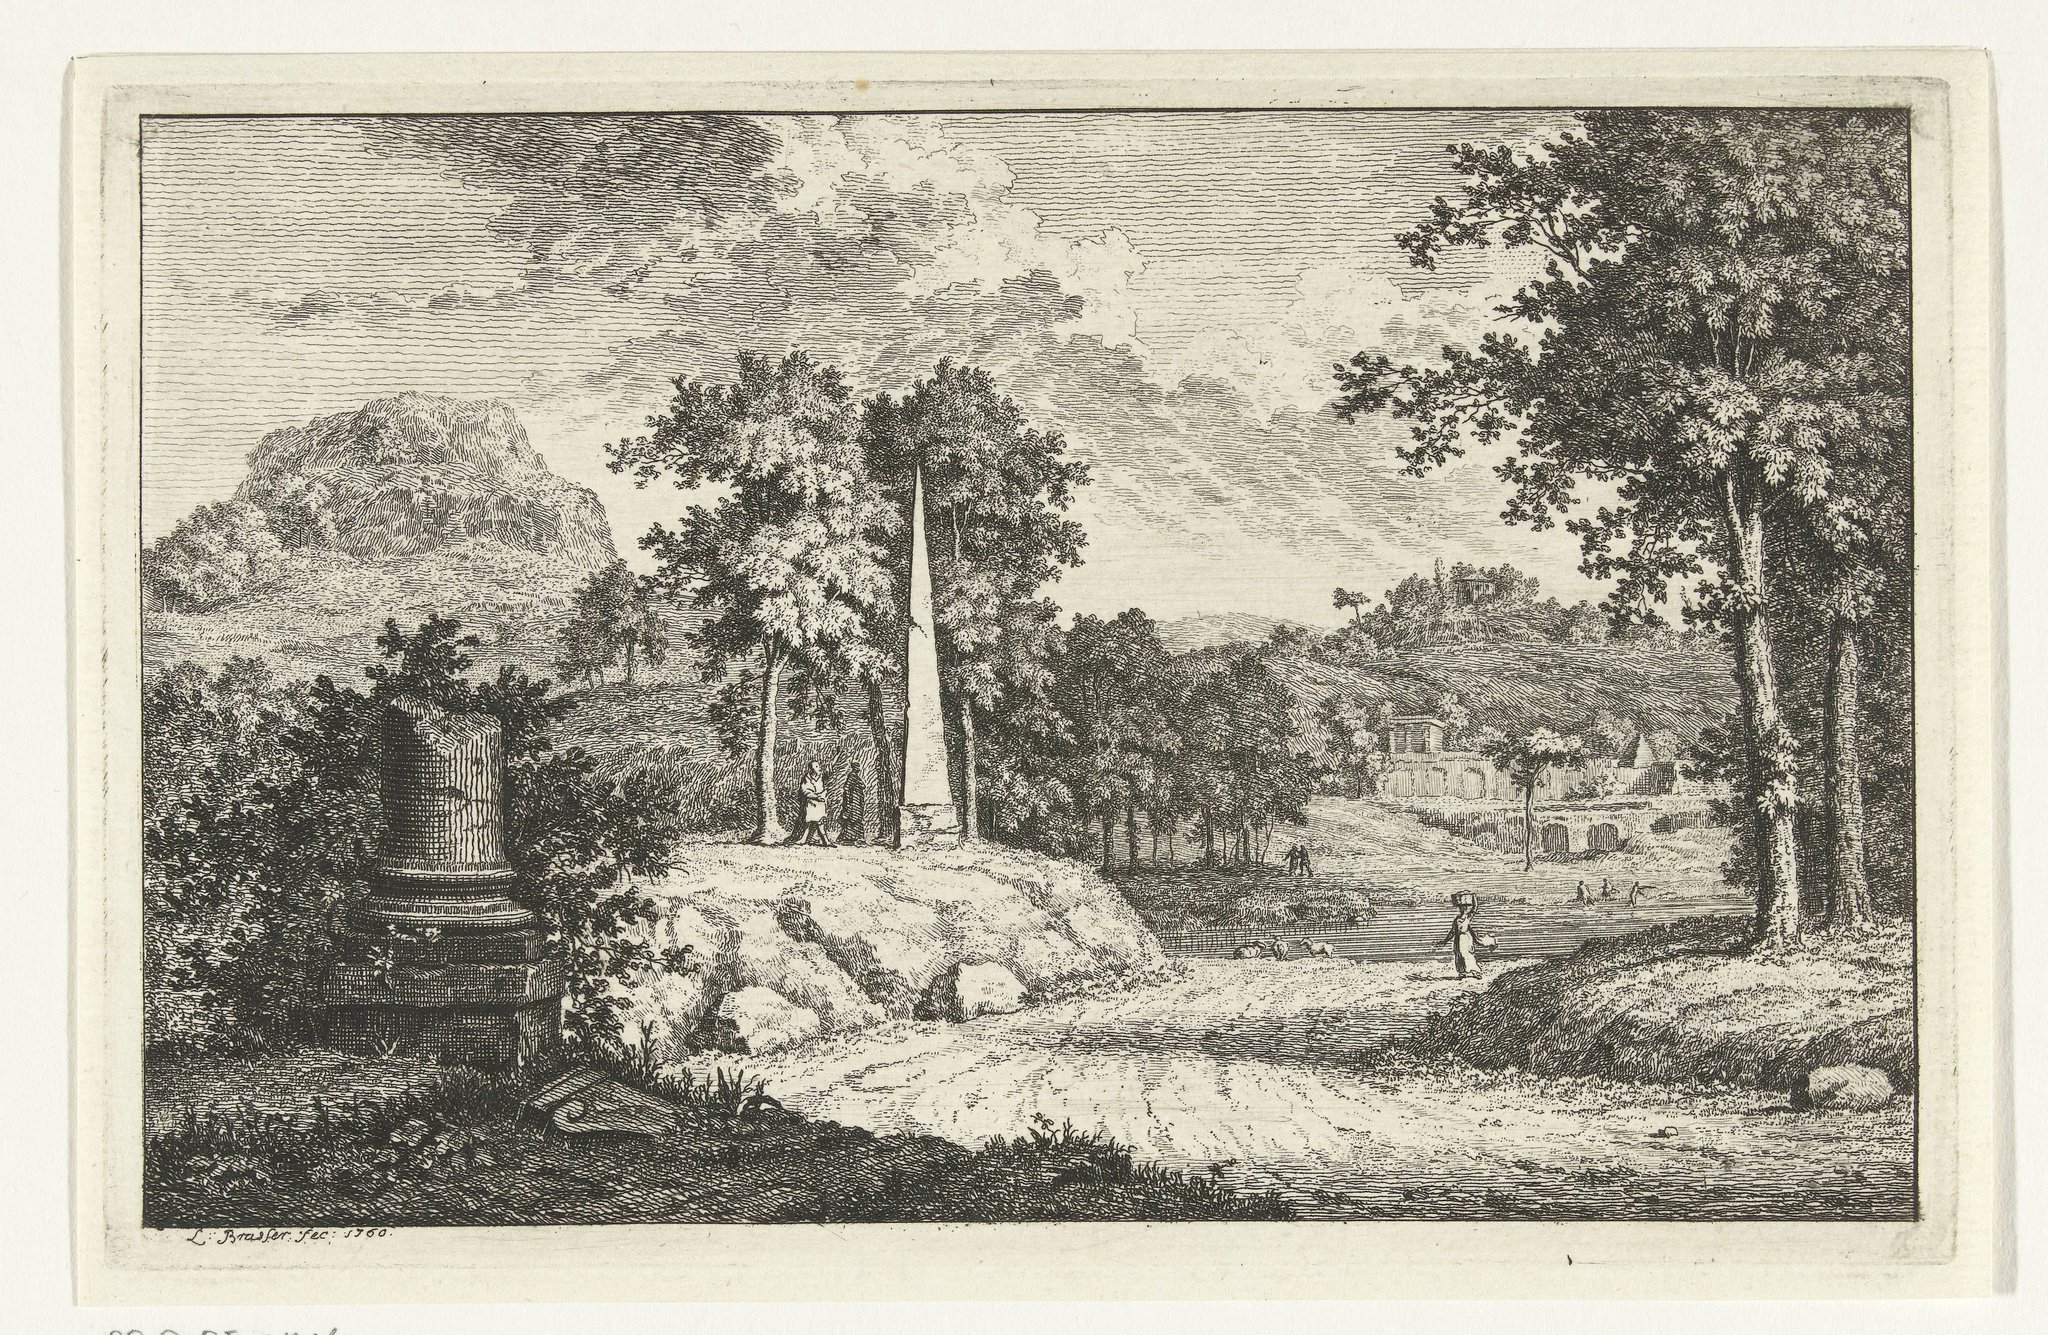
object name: print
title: Heuvelachtig landschap met obelisk langs de weg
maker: leendert brasser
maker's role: draughtsman, print maker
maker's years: 1727-1793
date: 1760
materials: paper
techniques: etching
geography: rotterdam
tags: (high) hill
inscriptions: collector's mark: Lugt 240